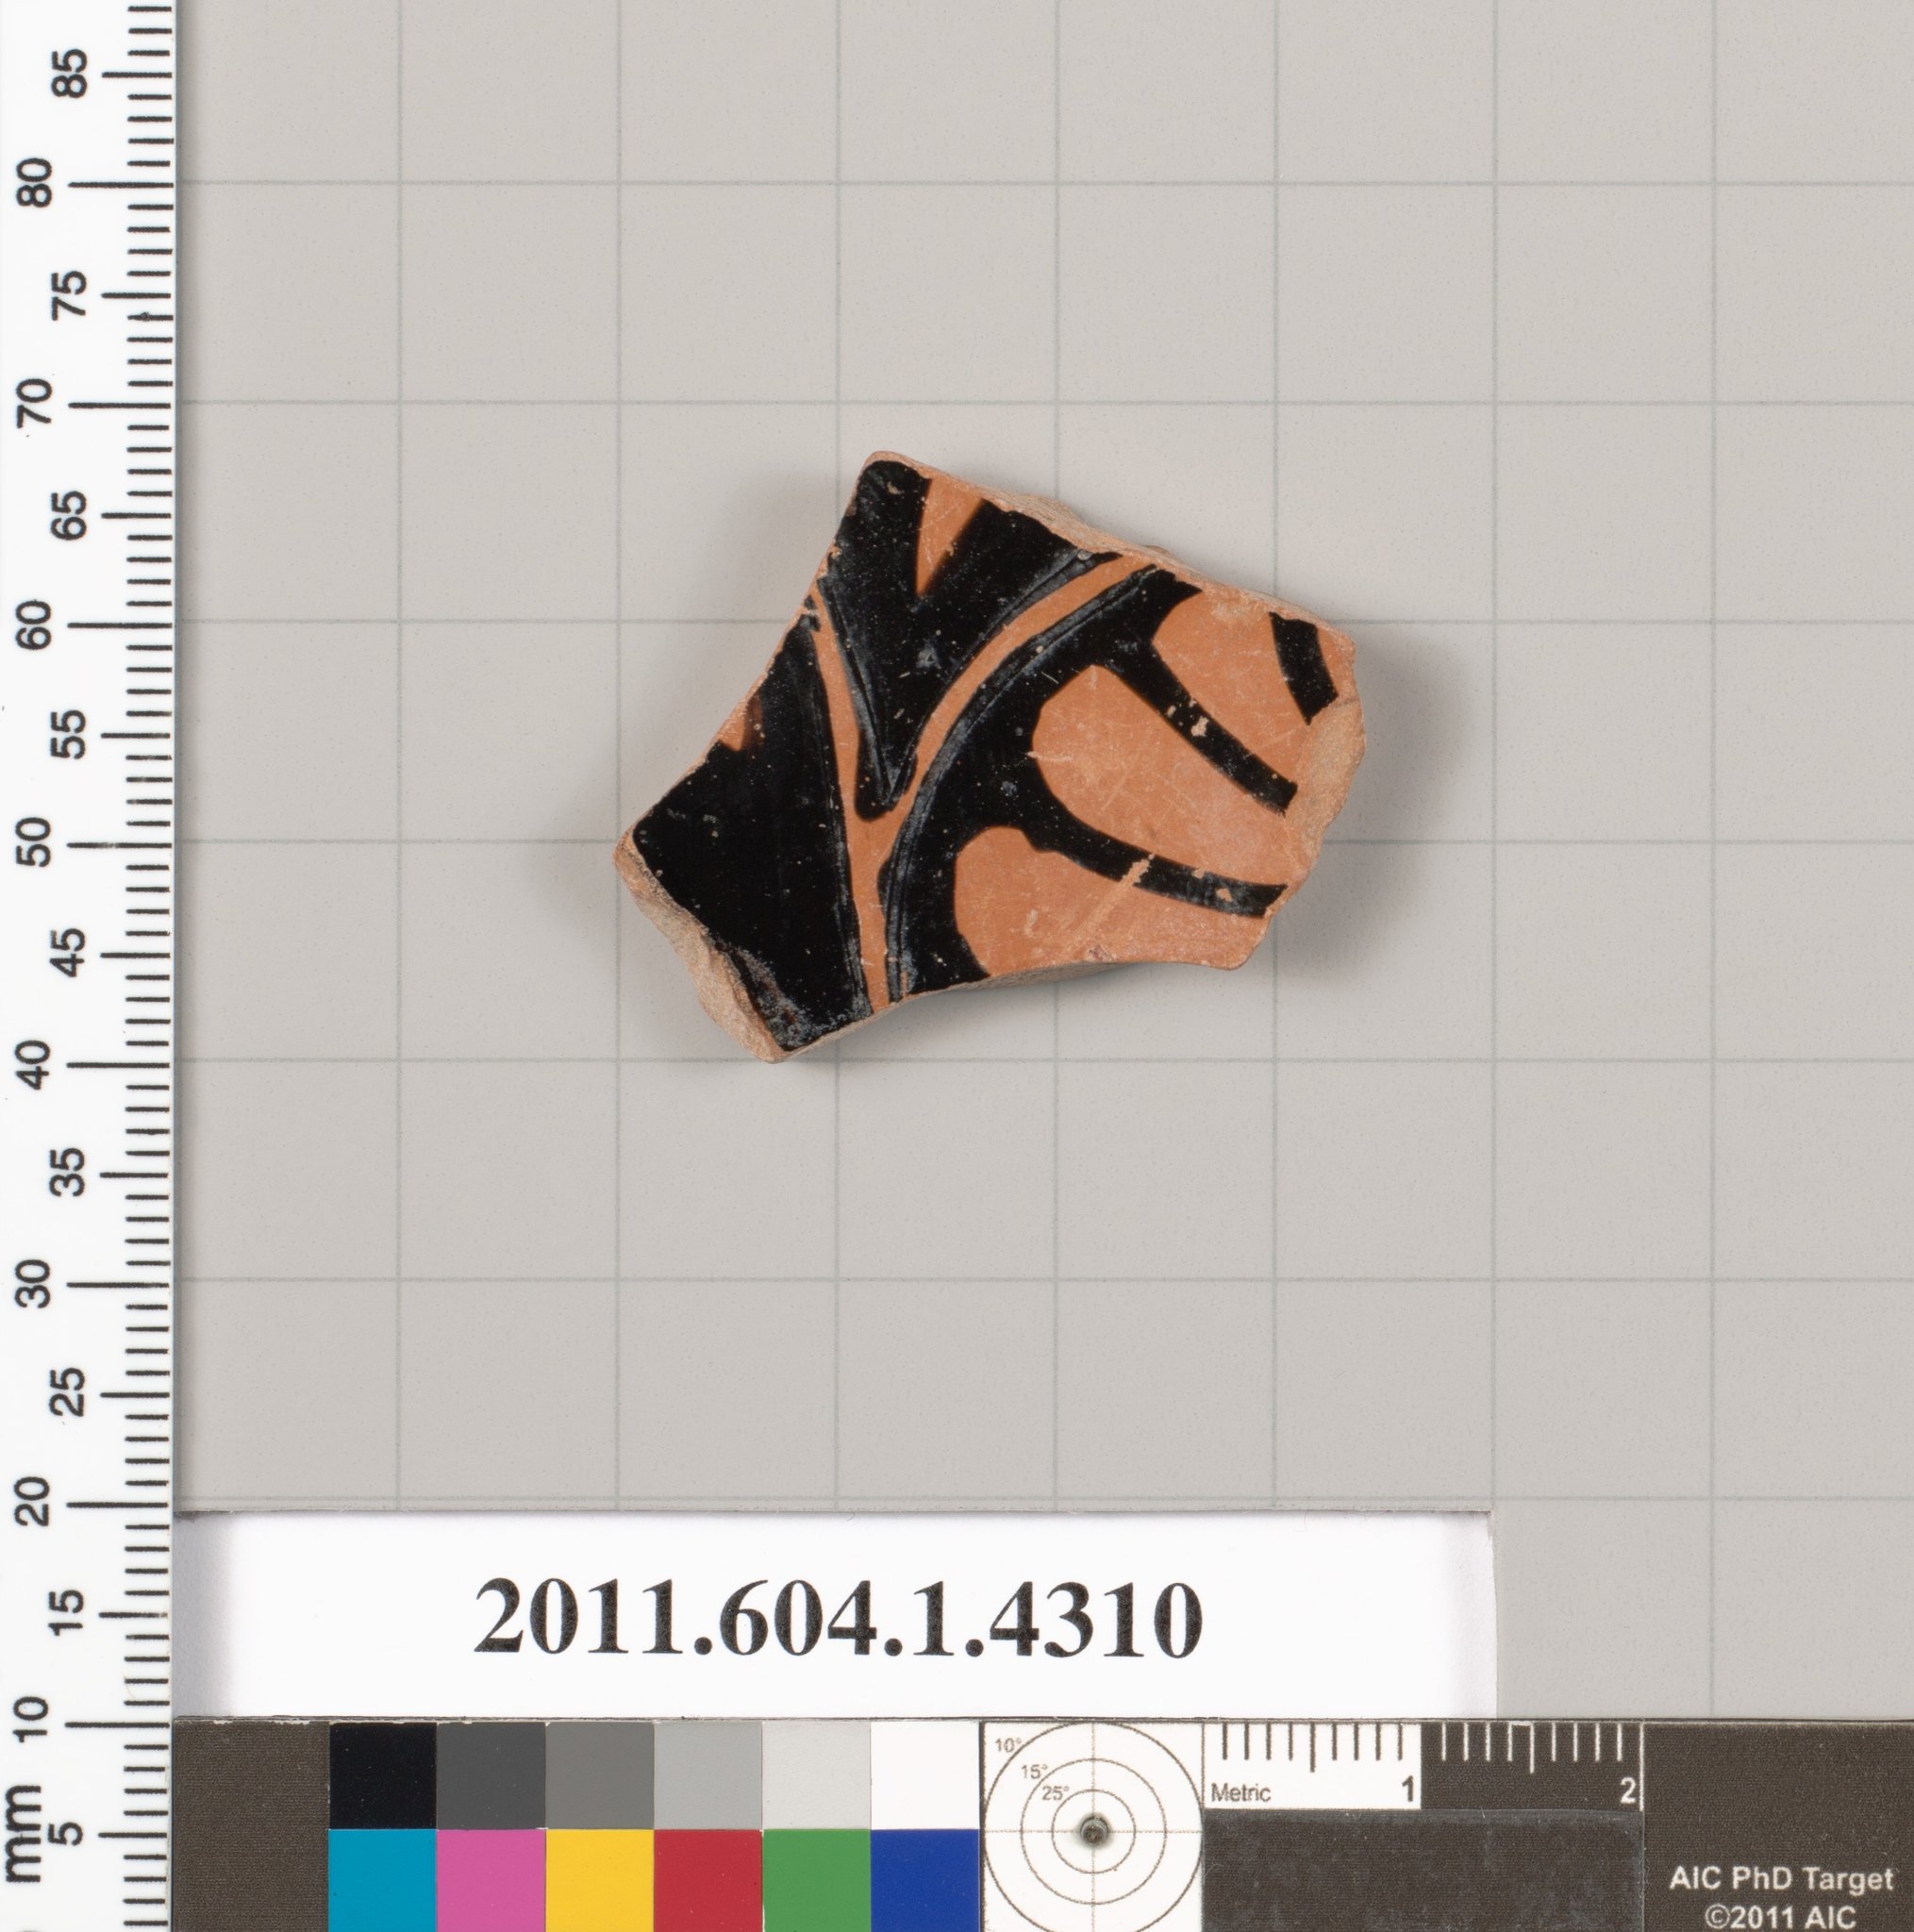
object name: kylix fragment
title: Terracotta fragment of a kylix (drinking cup)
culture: greek, attic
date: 500-451 BCE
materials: terracotta